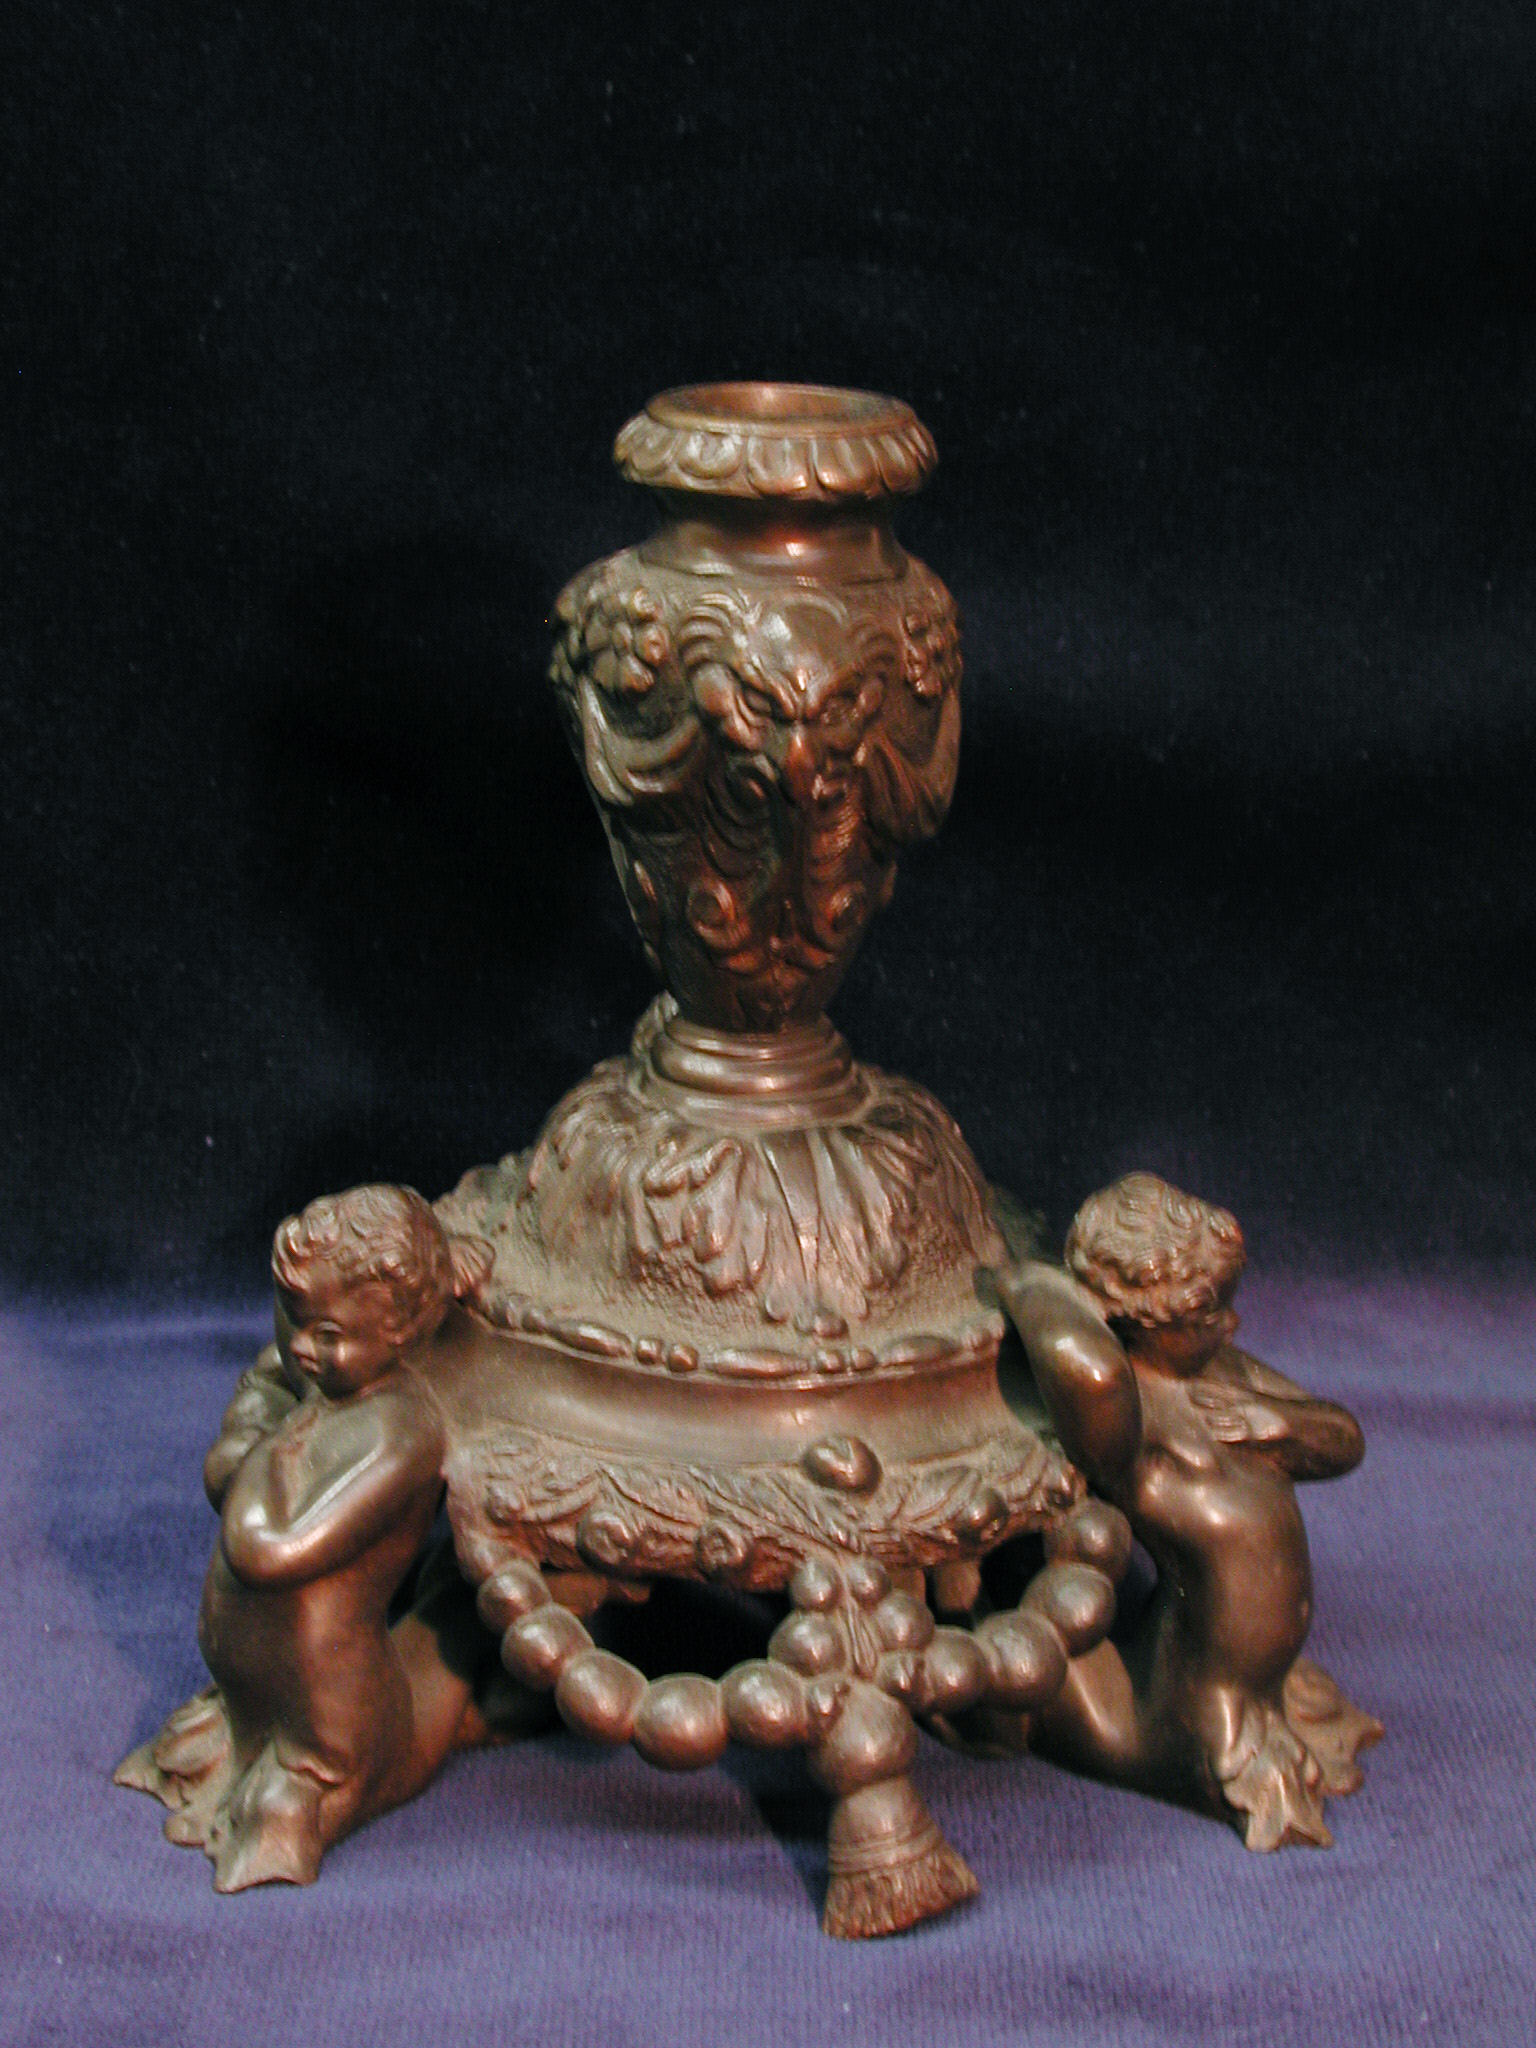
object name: candlestick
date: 1801-1900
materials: bronze